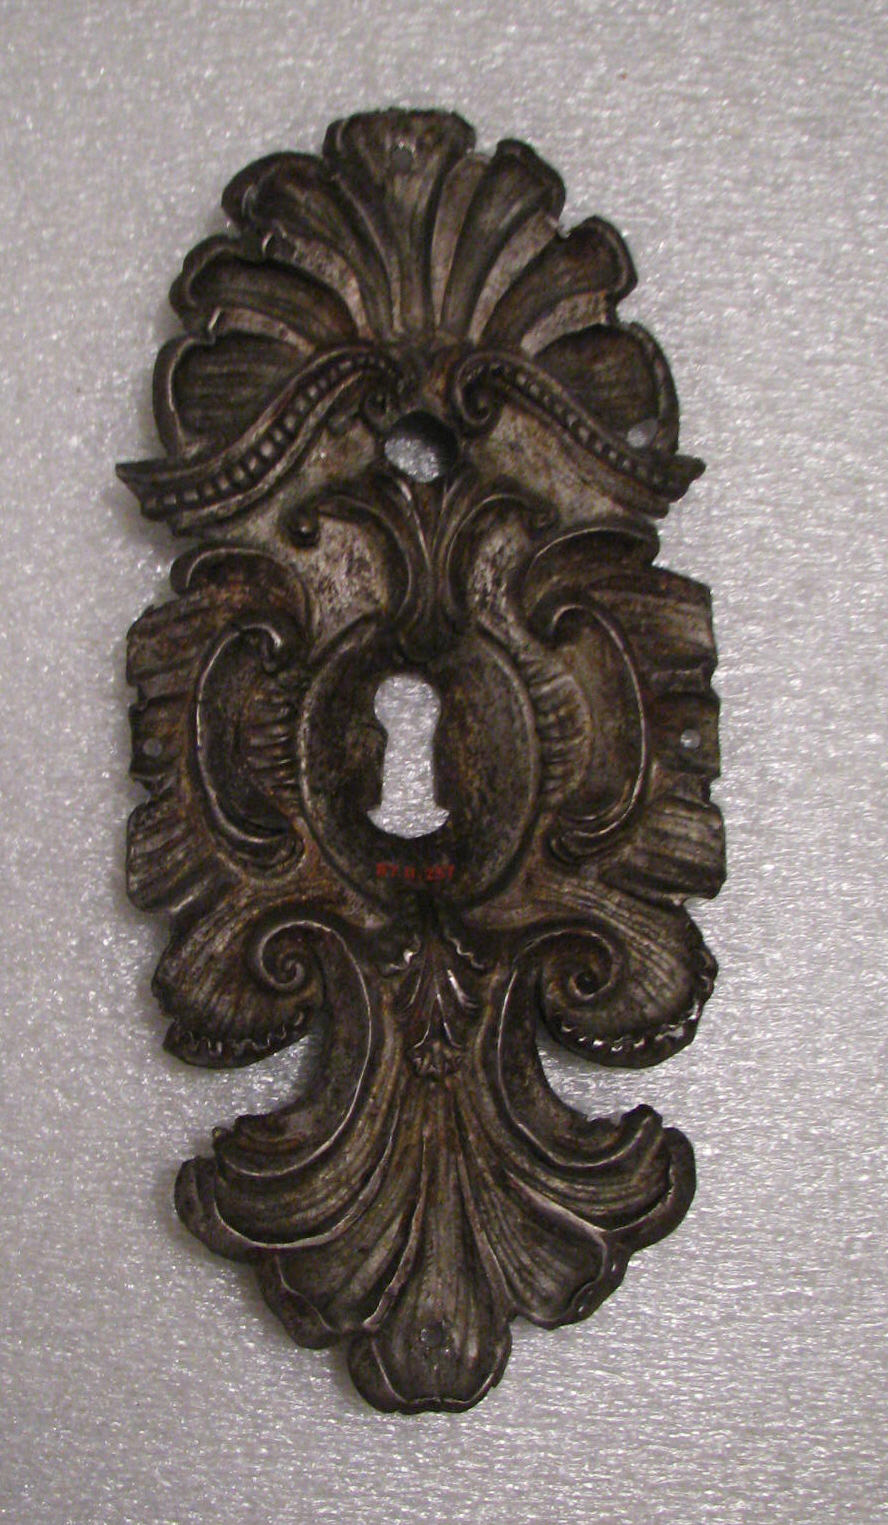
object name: escutcheon with lock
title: Escutcheon of lock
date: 1701-1750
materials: iron